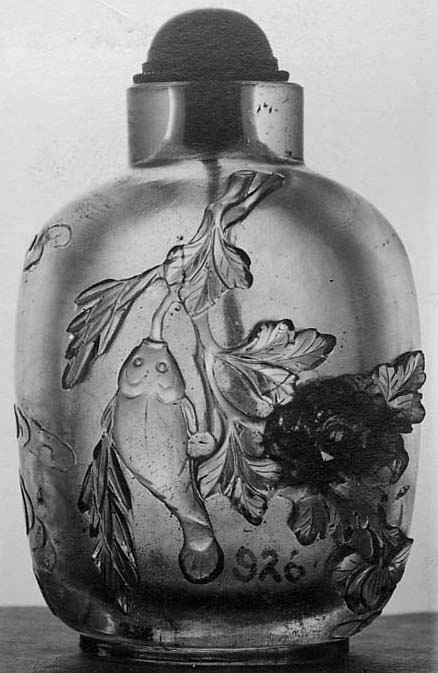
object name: snuff bottle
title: Snuff Bottle with Peony, Fish, and Bat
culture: chinese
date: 1801-1900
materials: jade, quartz